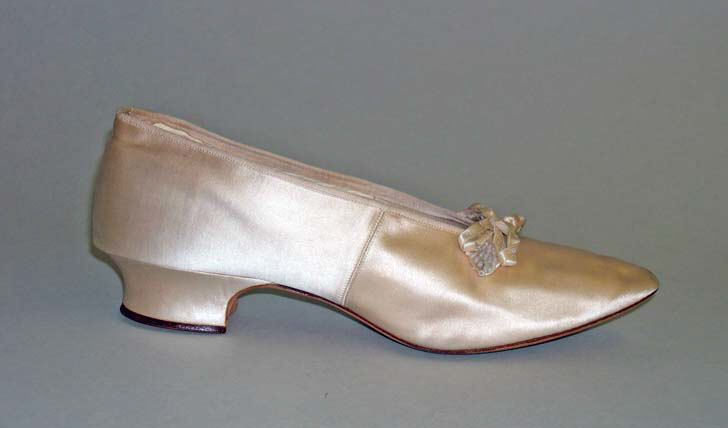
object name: slipper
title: Slippers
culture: american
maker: j. & j. slater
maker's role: designer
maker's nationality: american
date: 1894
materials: leather